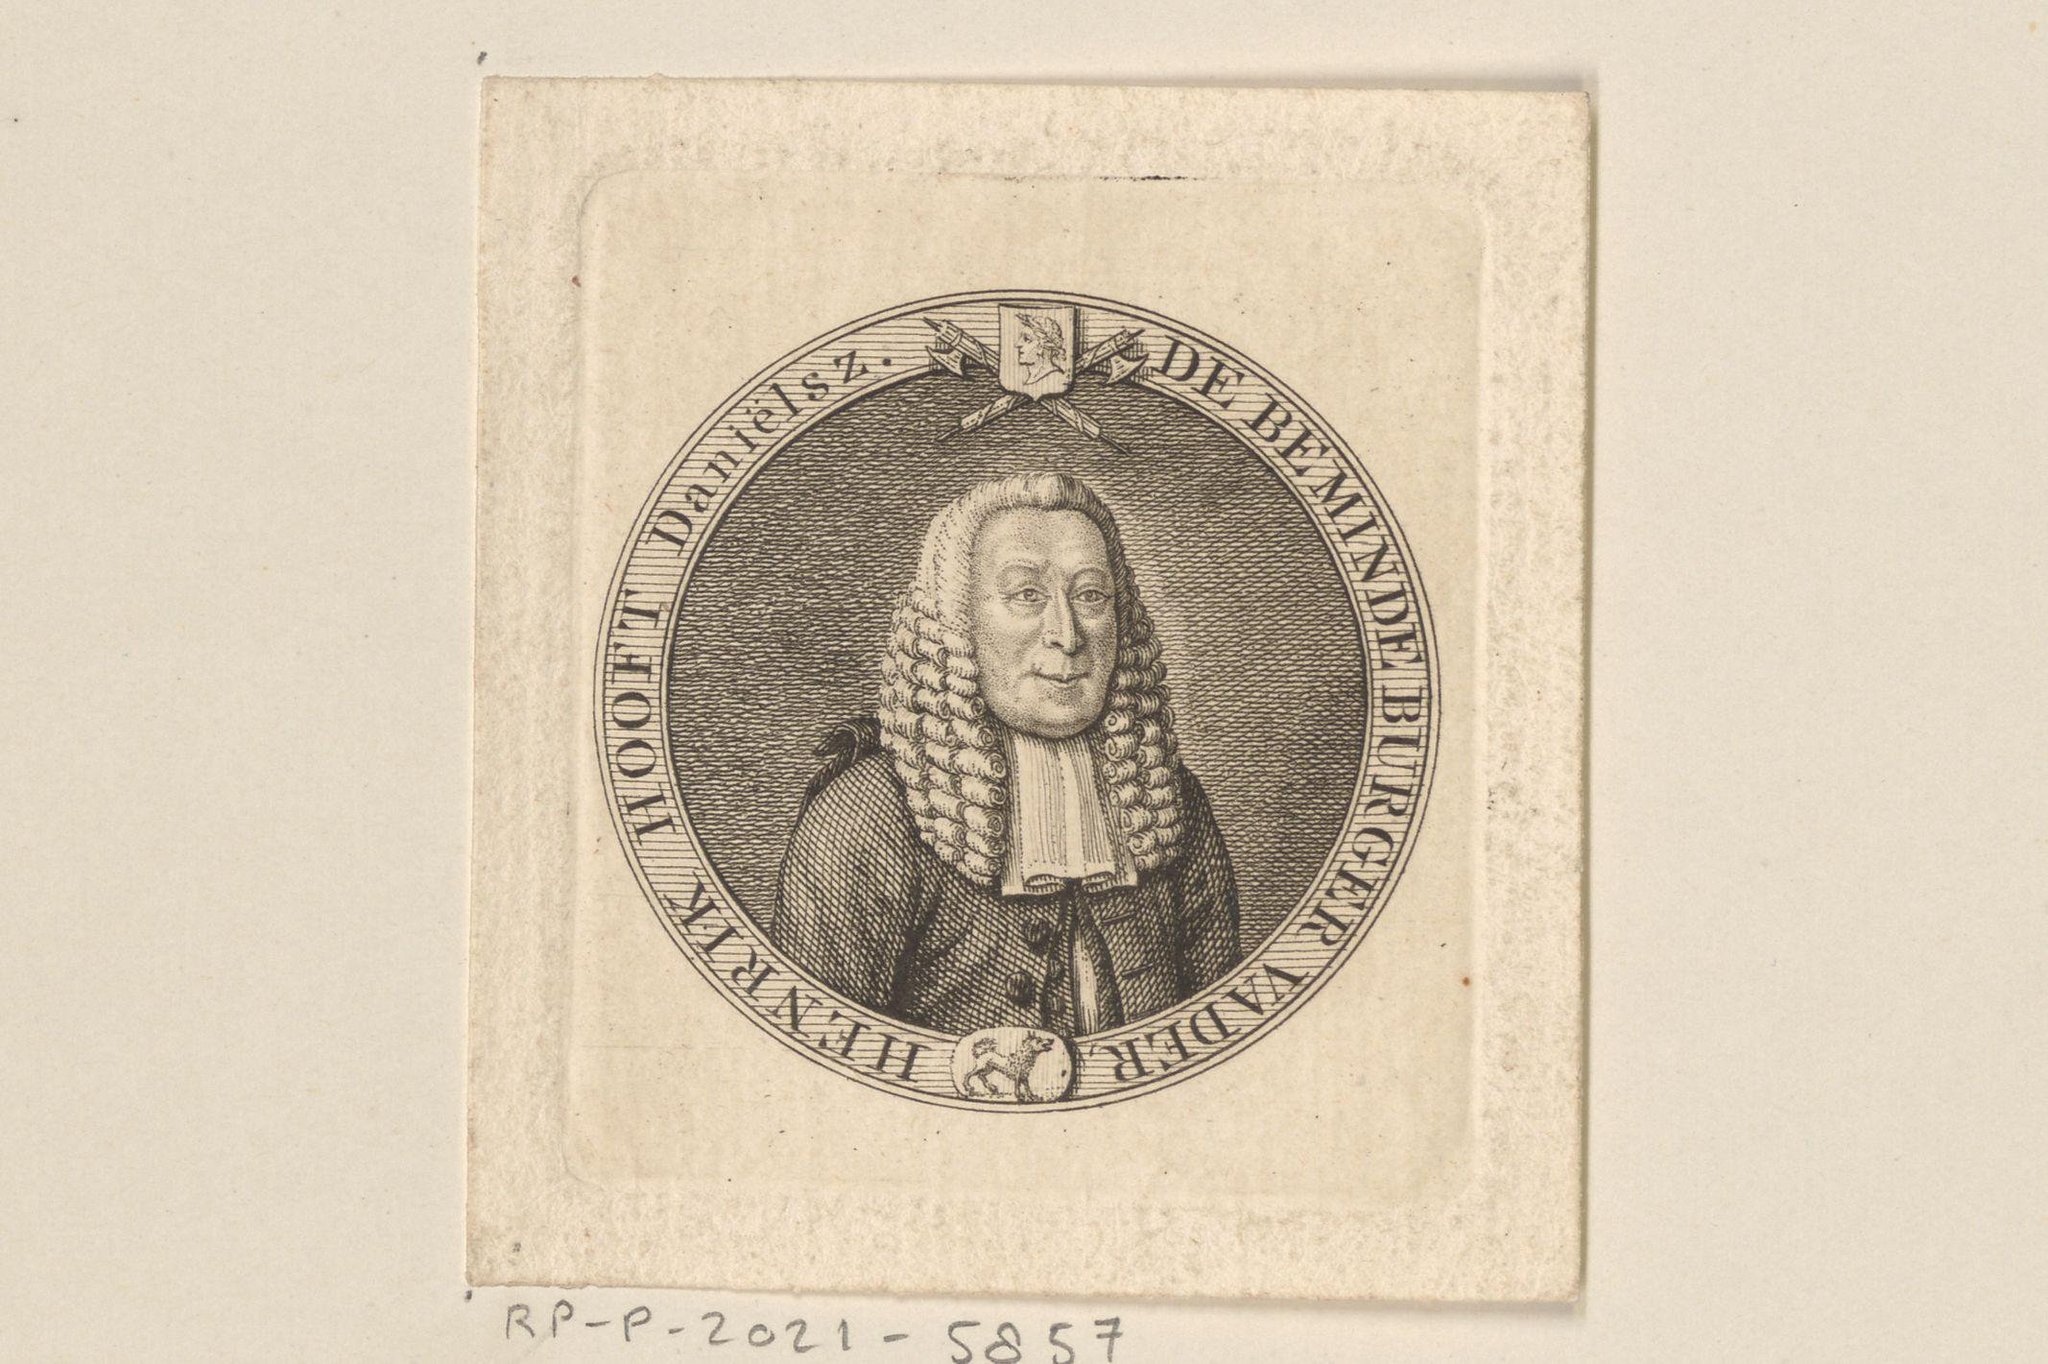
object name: print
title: Portret van Hendrik Danielsz. Hooft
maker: Anonymous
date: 1769-1799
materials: paper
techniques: etching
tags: amsterdam, mayor, hendrik danielsz. hooft, mayor, burgomaster, historical persons, book